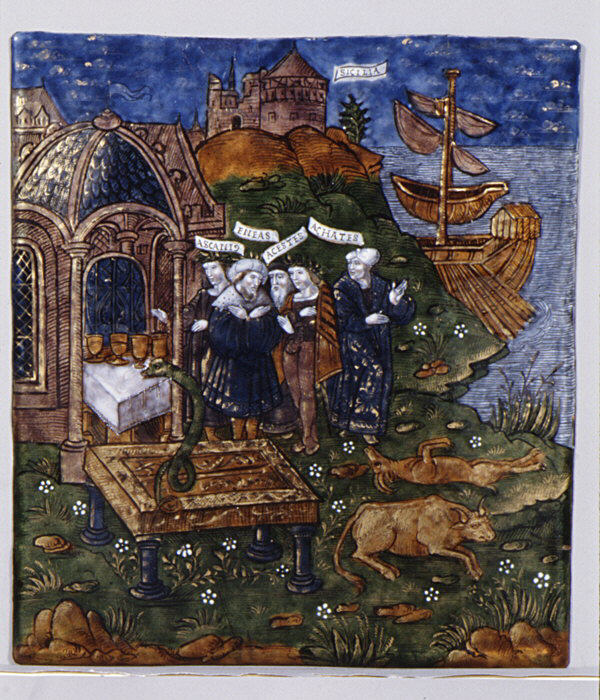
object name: plaque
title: Aeneas and His Companions Sacrifice to the Gods before the Tomb of his Father, Anchises, in Sicily (Aeneid, Book V)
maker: master of the aeneid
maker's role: artist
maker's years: 1525-1545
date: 1530-1535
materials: copper, enamel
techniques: gilding, painting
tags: tombs,men,aeneas,cows,deer